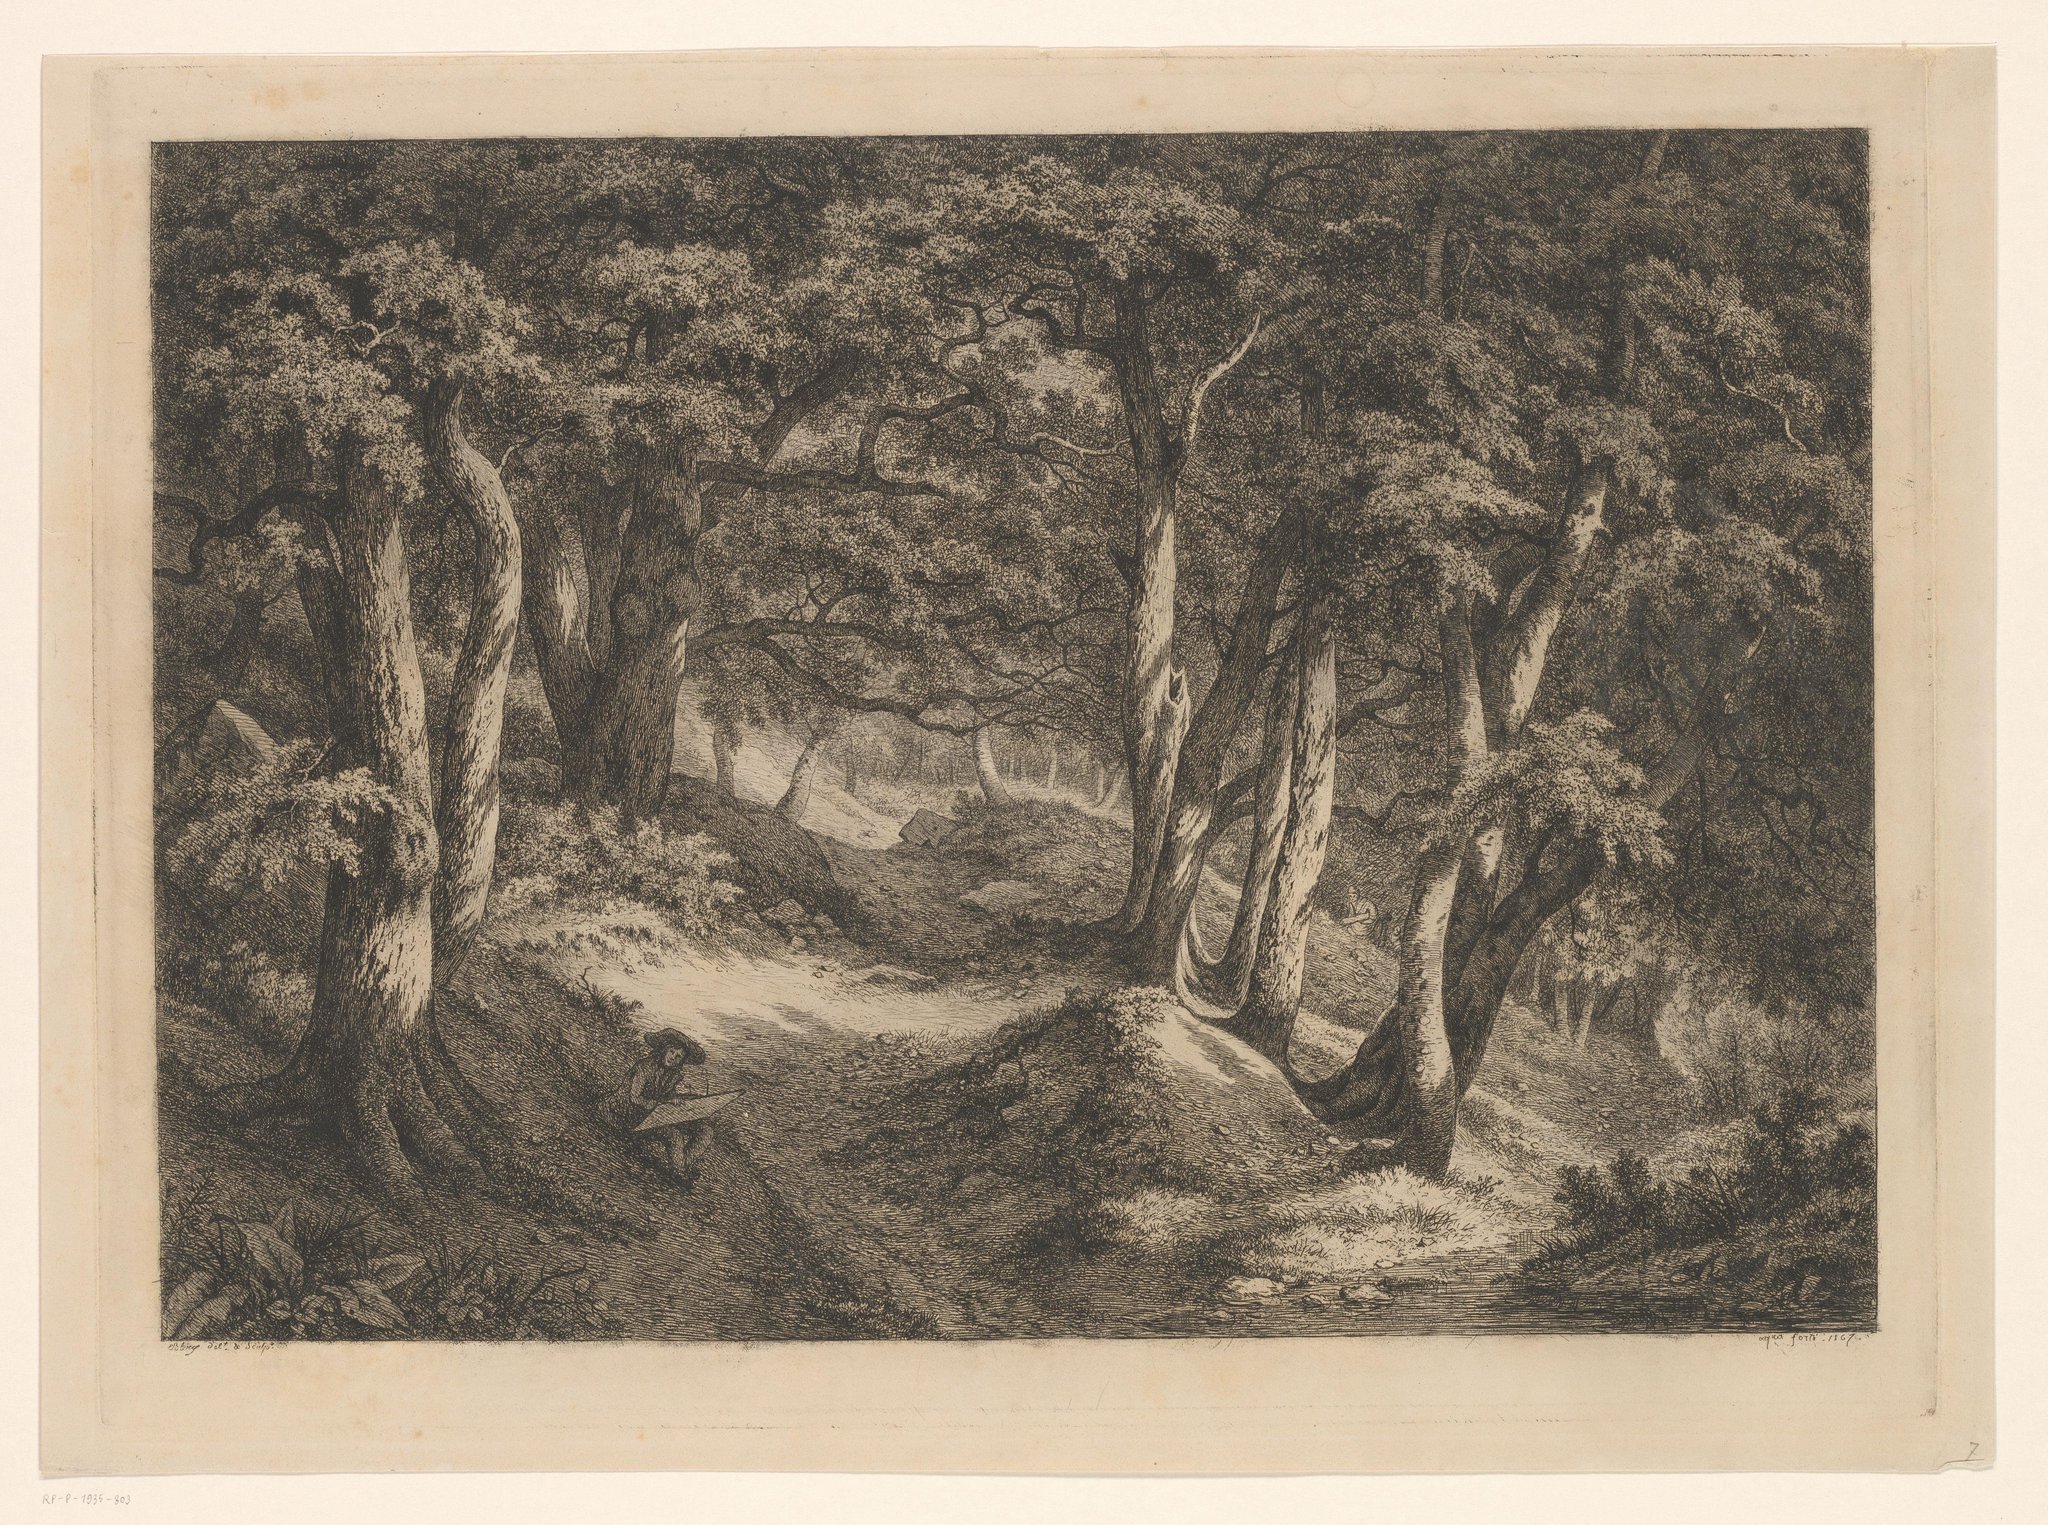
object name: print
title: Boslandschap met tekenaar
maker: eugène bléry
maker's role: print maker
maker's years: 1805-1887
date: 1867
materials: paper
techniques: aquatint, drypoint, engraving, etching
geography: france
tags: draughtsman at work, forest, wood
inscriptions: collector's mark: Lugt 2228